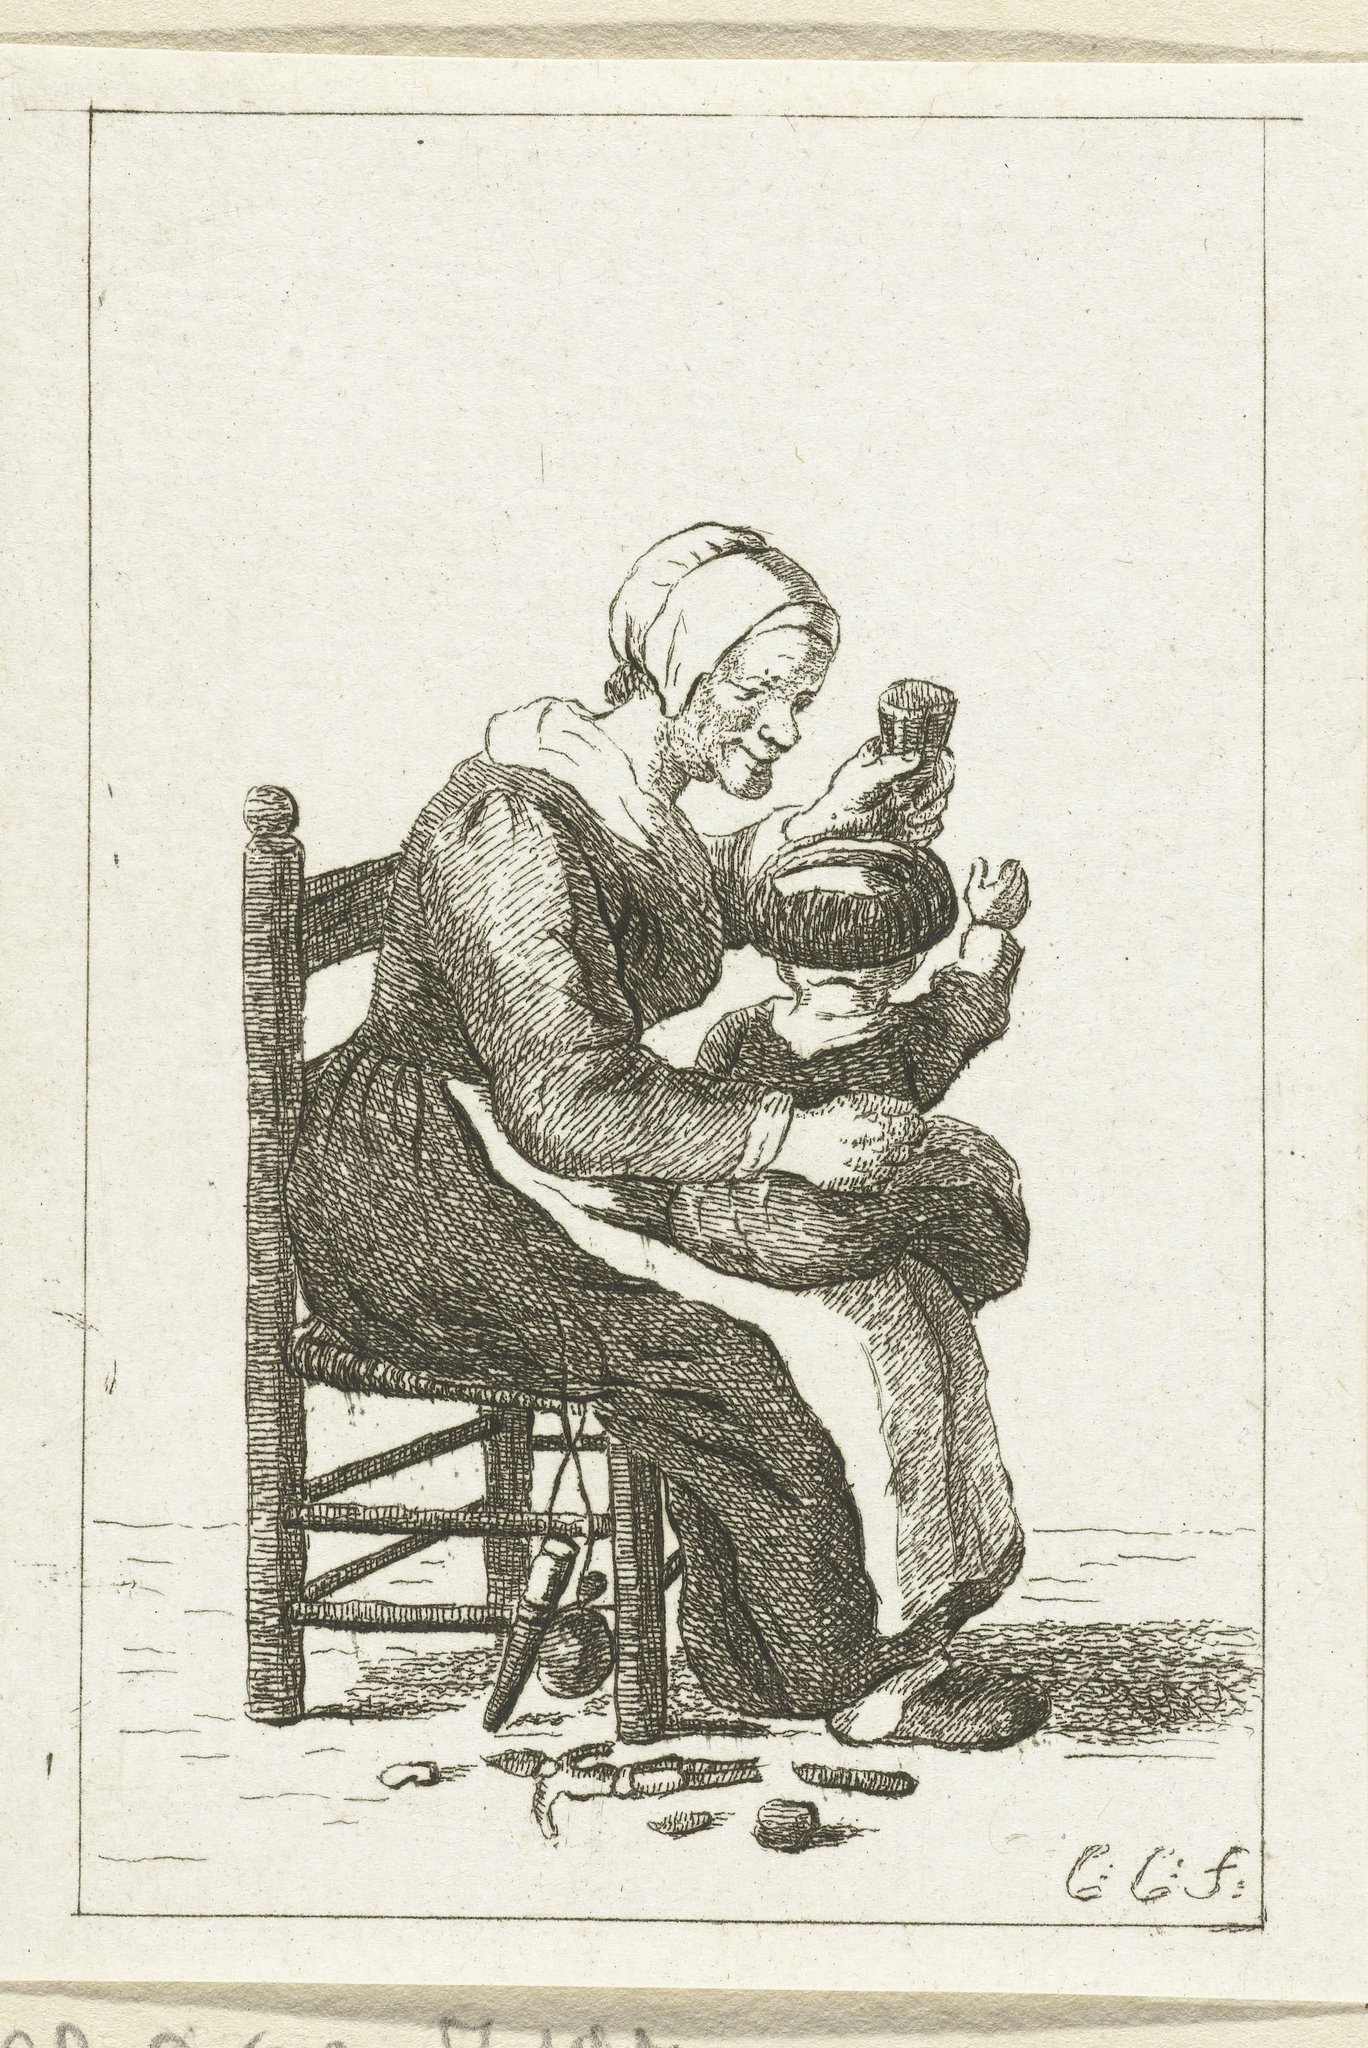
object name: print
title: Vrouw met kind op schoot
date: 1779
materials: paper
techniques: etching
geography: leiden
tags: (playing with) toys, drinking, mother and child(ren), woman and child(ren) (family group) (with number of children)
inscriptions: collector's mark: Lugt 2228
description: Moeder met kind op de schoot. Ze probeert het kind uit een beker te laten drinken. Op de grond wat speelgoed. Profiel naar rechts.